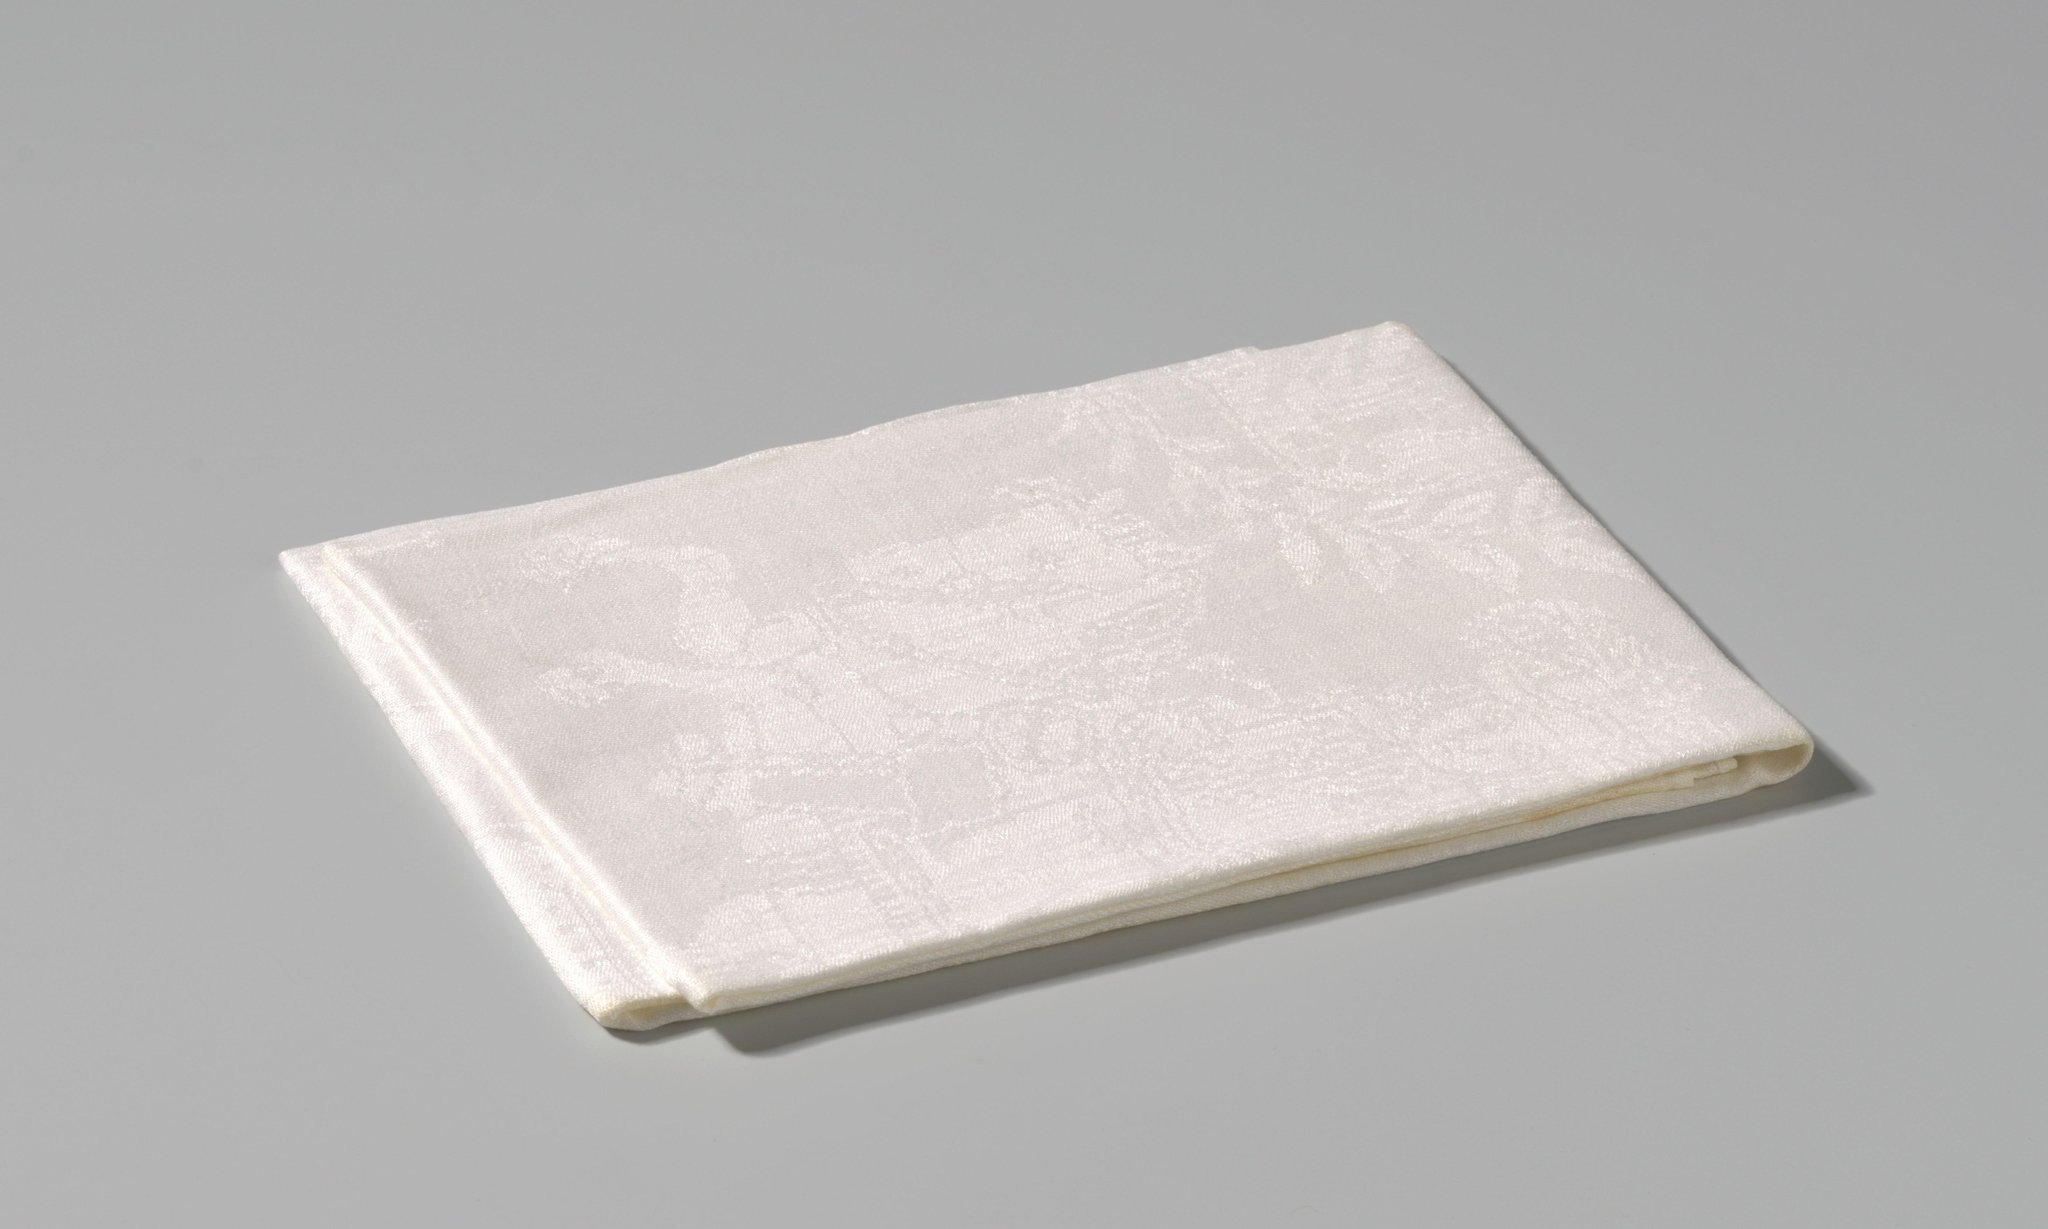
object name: napkin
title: Servet met de verovering van Neuhäusel, Gran, Buda en Pest door Leopold I, keizer van Duitsland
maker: Anonymous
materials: linen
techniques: damask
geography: flanders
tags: leopold i (keizer van duitsland)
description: Servet van linnendamast met de verovering van Neuhäusel, Gran, Buda en Pest door Leopold I; met het wapen van het Heilige Roomse Rijk met hartschild Oosterijk.